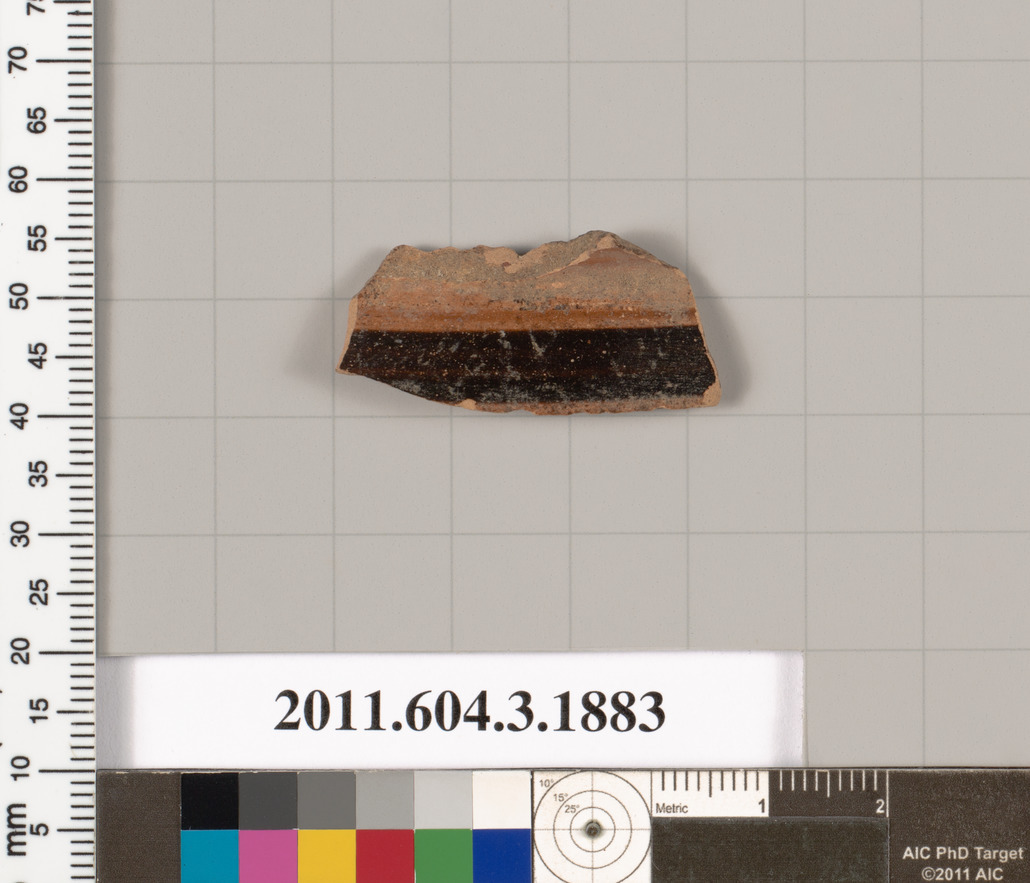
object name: mastoid fragment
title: Terracotta fragment of a mastoid (drinking cup with narrow base) ?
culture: greek, attic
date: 534-468 BCE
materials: terracotta